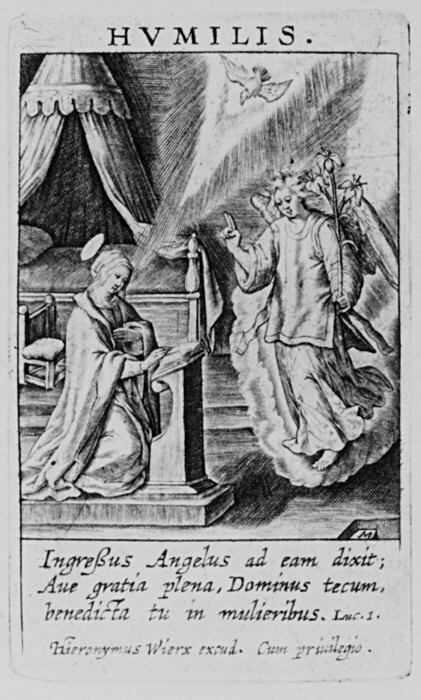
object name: print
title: The Annunciation (Humilis)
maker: hieronymus wierix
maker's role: artist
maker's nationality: netherlandish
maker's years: 1553-1619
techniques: engraving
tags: angels,virgin mary,annunciation,beds